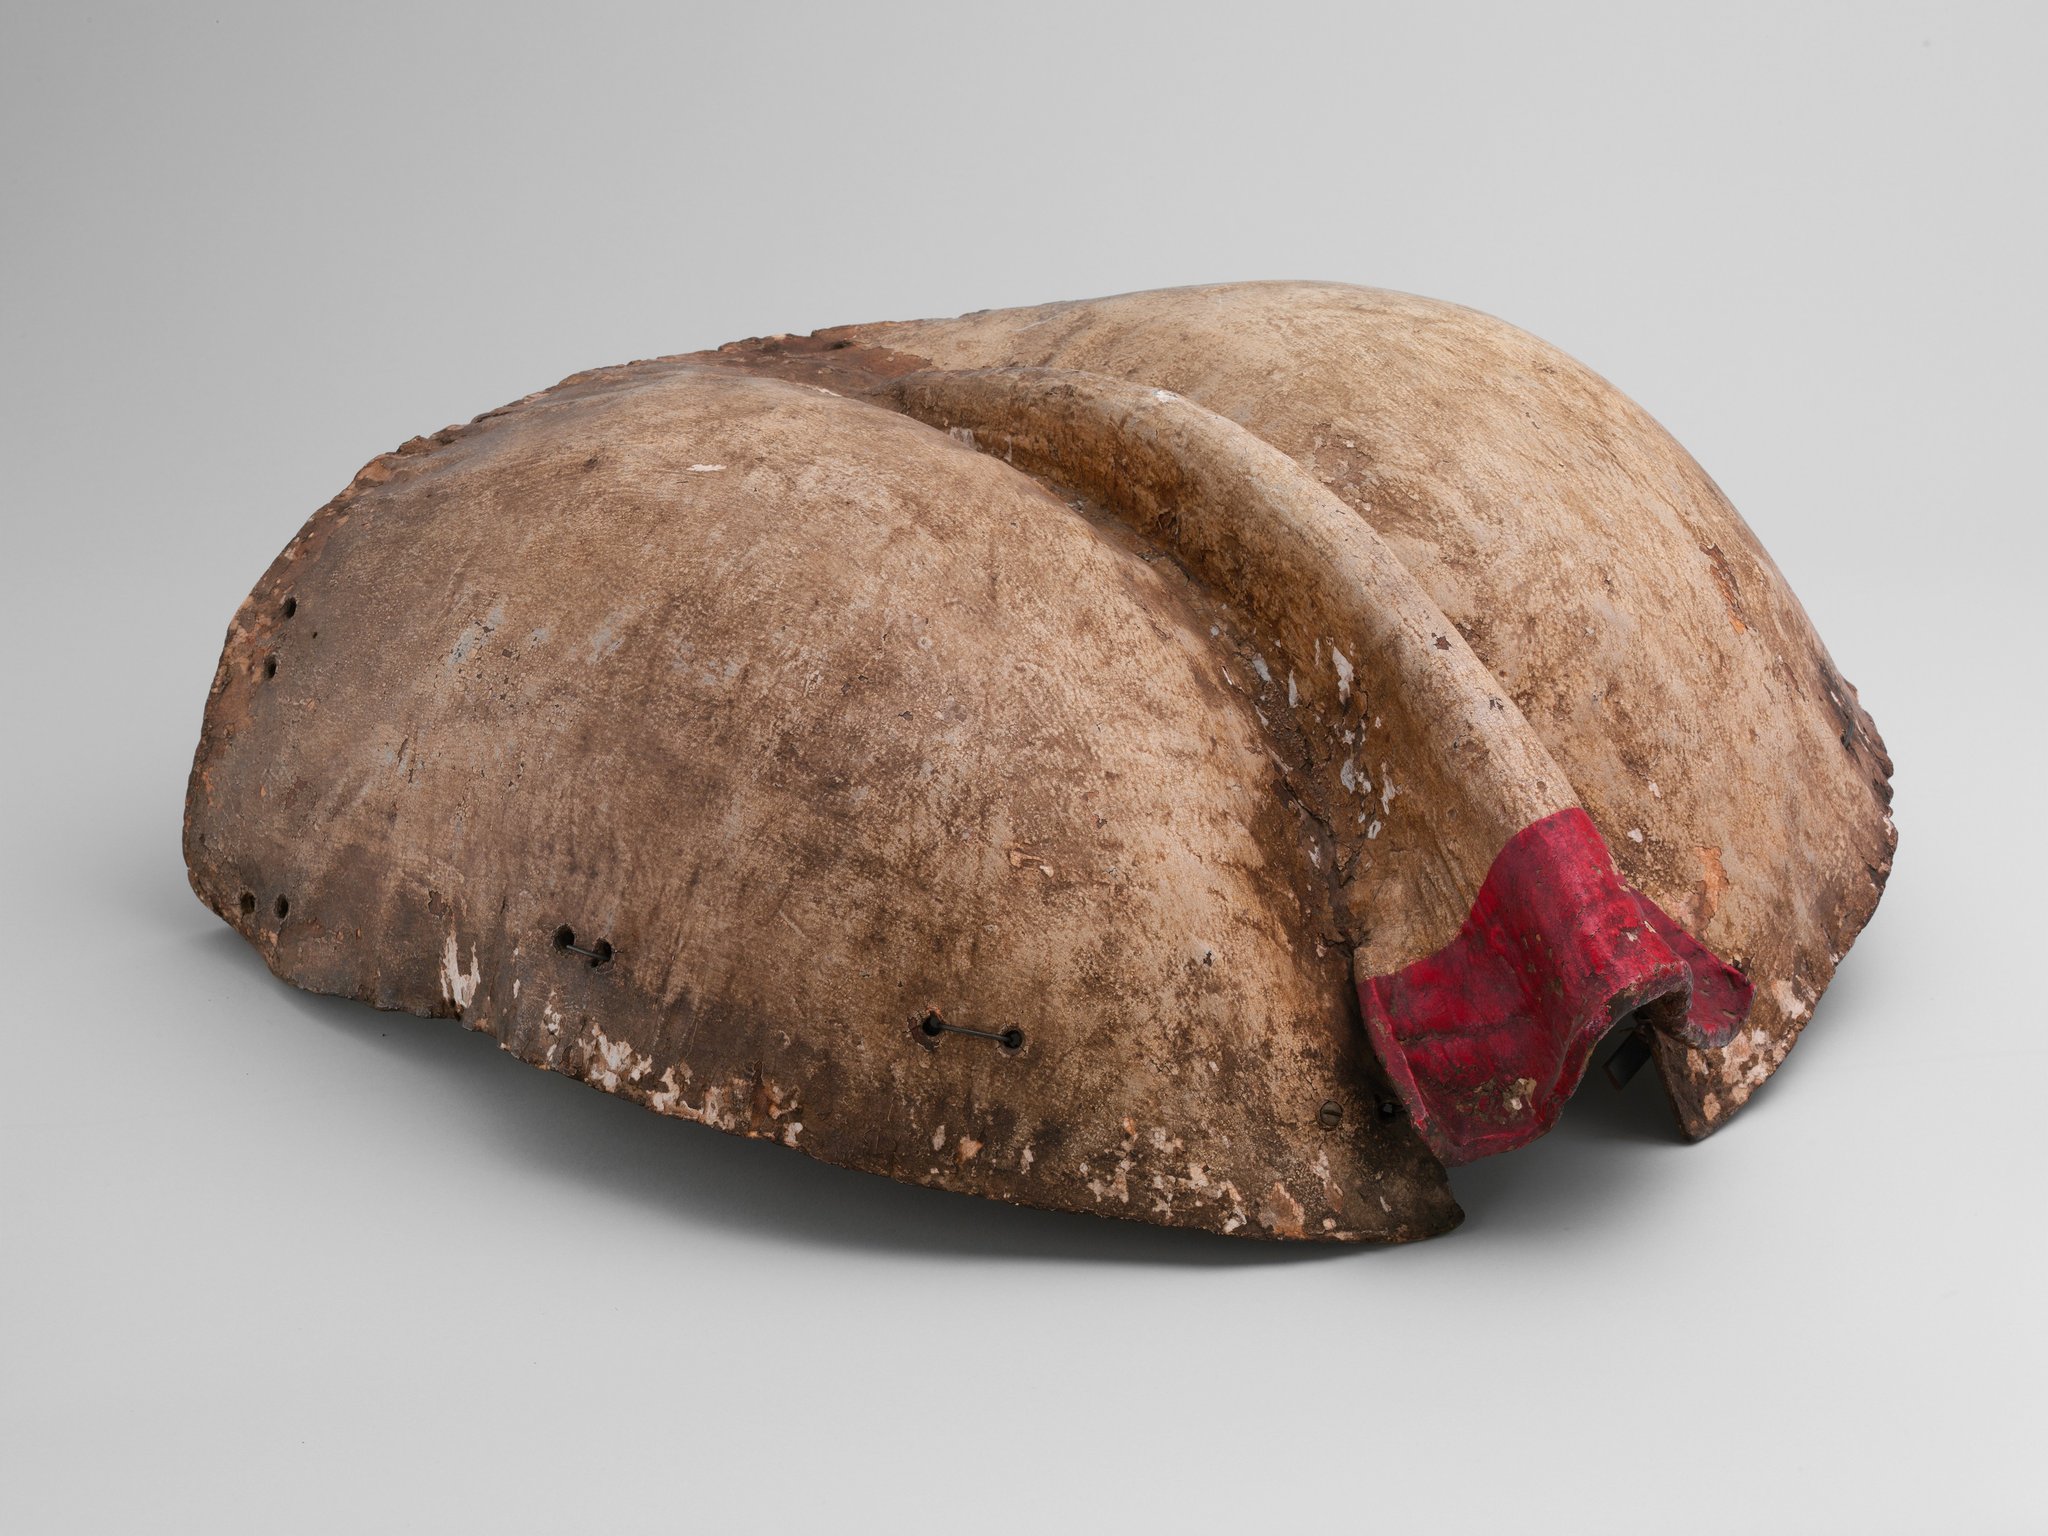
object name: peytral and crupper plate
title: Peytral and Crupper Plates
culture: flemish or german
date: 1501-1533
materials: gesso, leather, pigment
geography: belgium